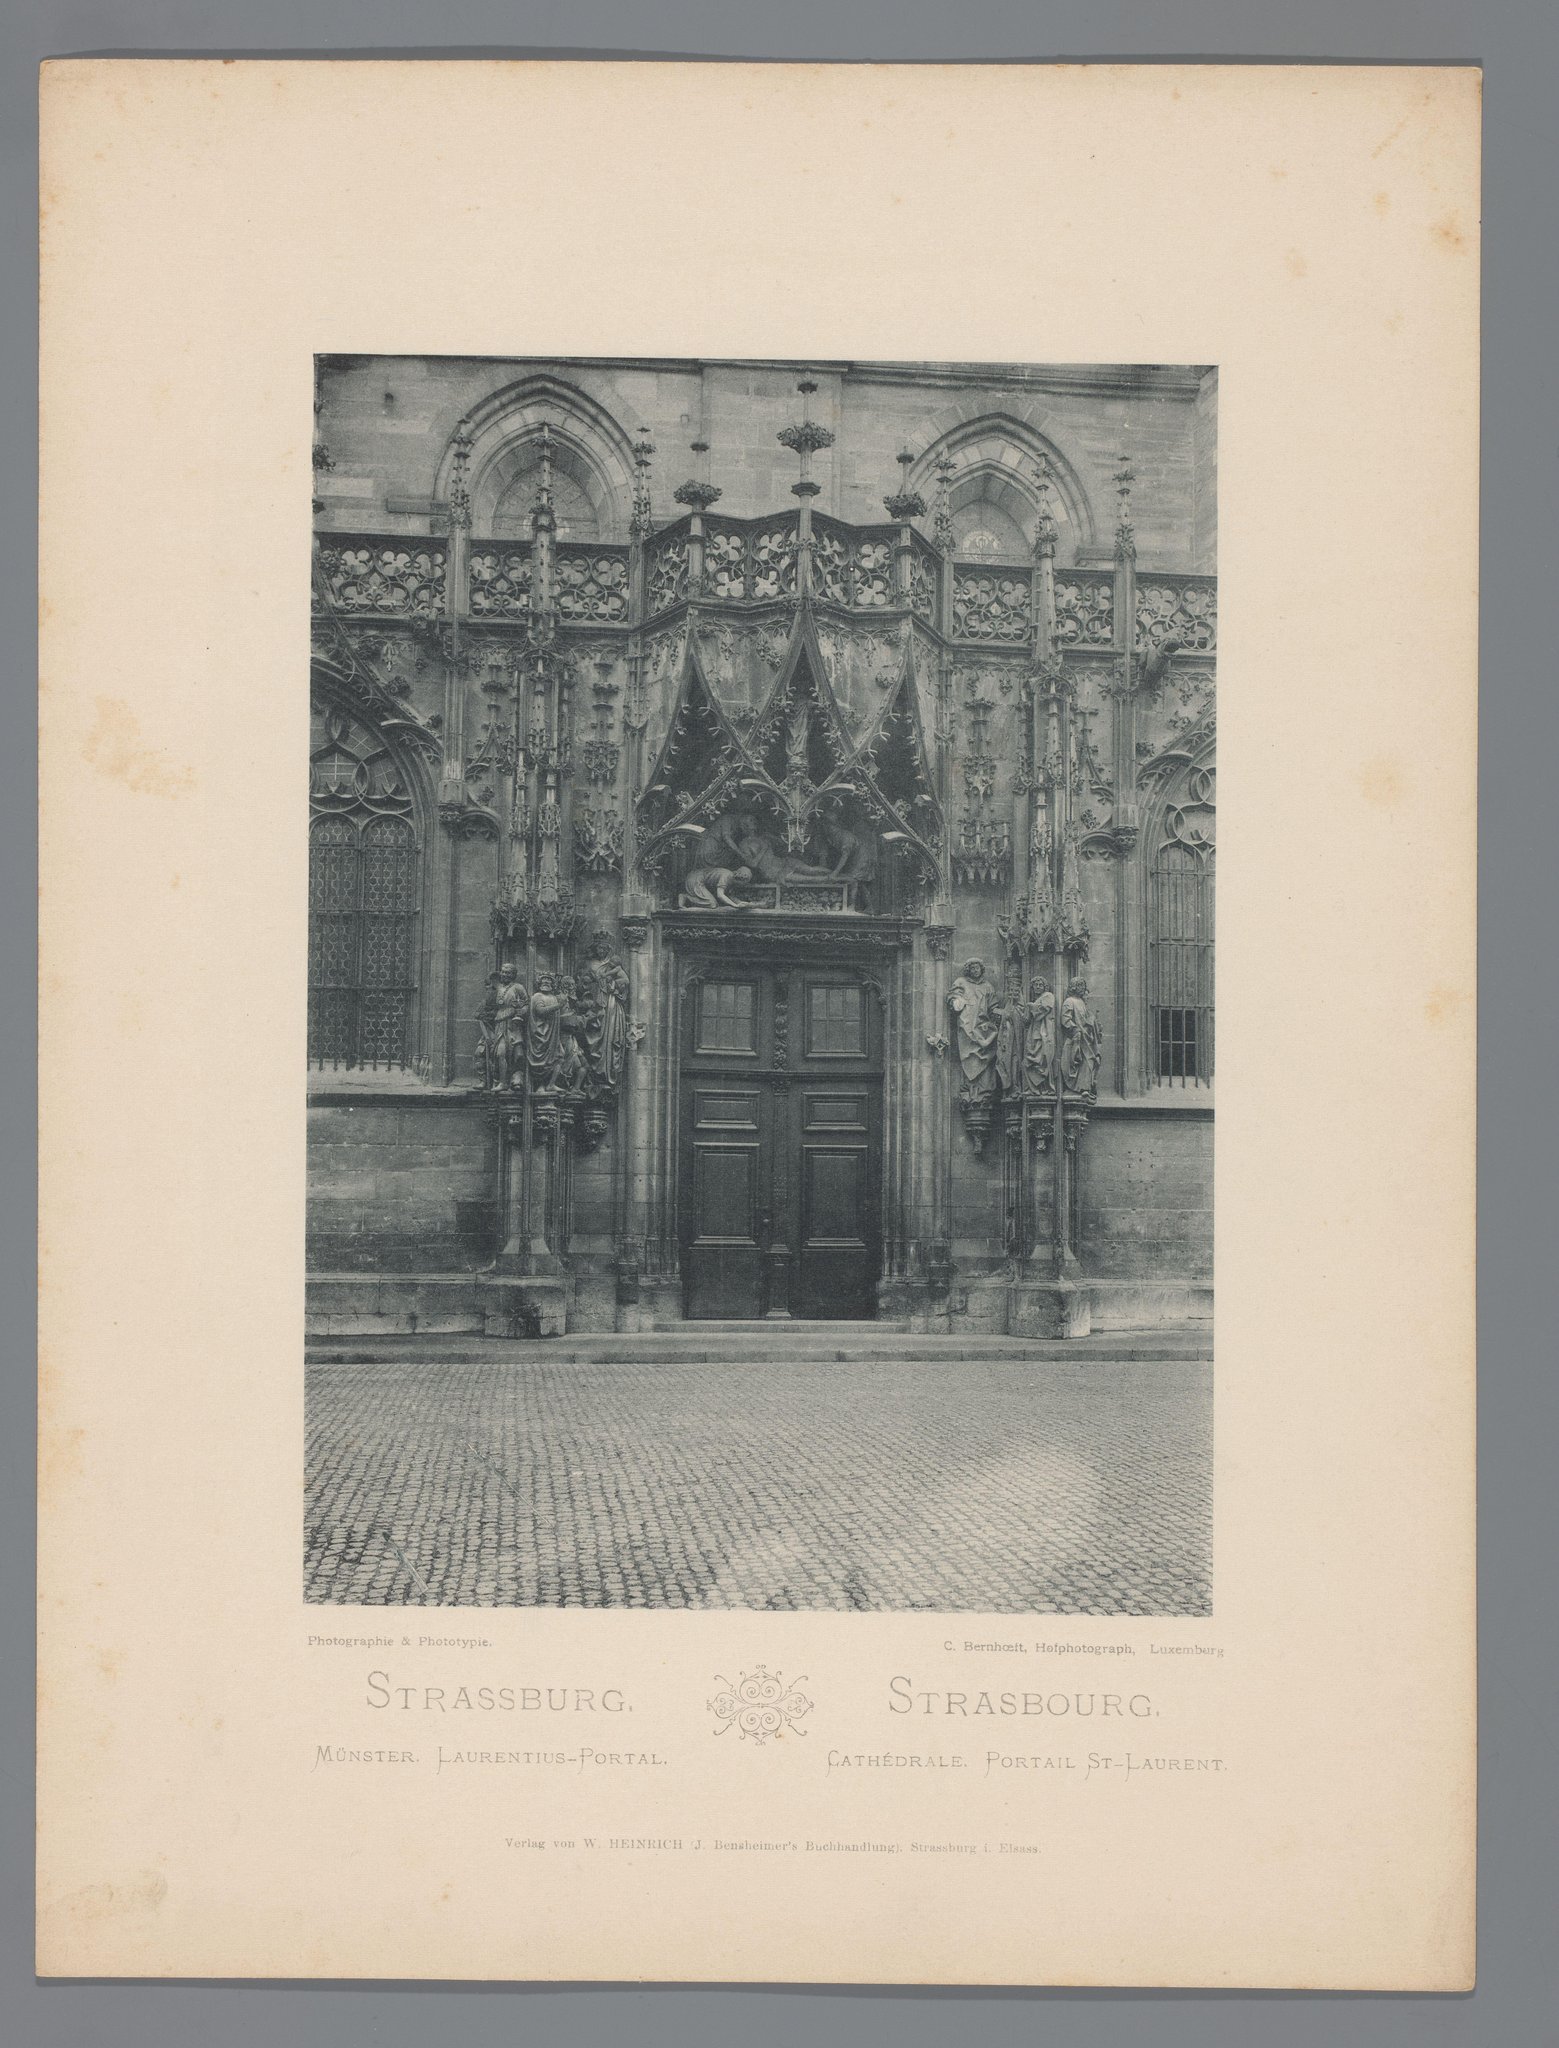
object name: photomechanical print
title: Portaal van de Sint-Laurentiuskapel van de kathedraal van Straatsburg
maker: charles bernhoeft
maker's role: publisher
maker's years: 1859-1933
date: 1889-1894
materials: paper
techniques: photograph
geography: straatsburg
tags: parts of church exterior and annexes: portal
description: Deze prent maakt deel uit van een omslag met 100 prenten.